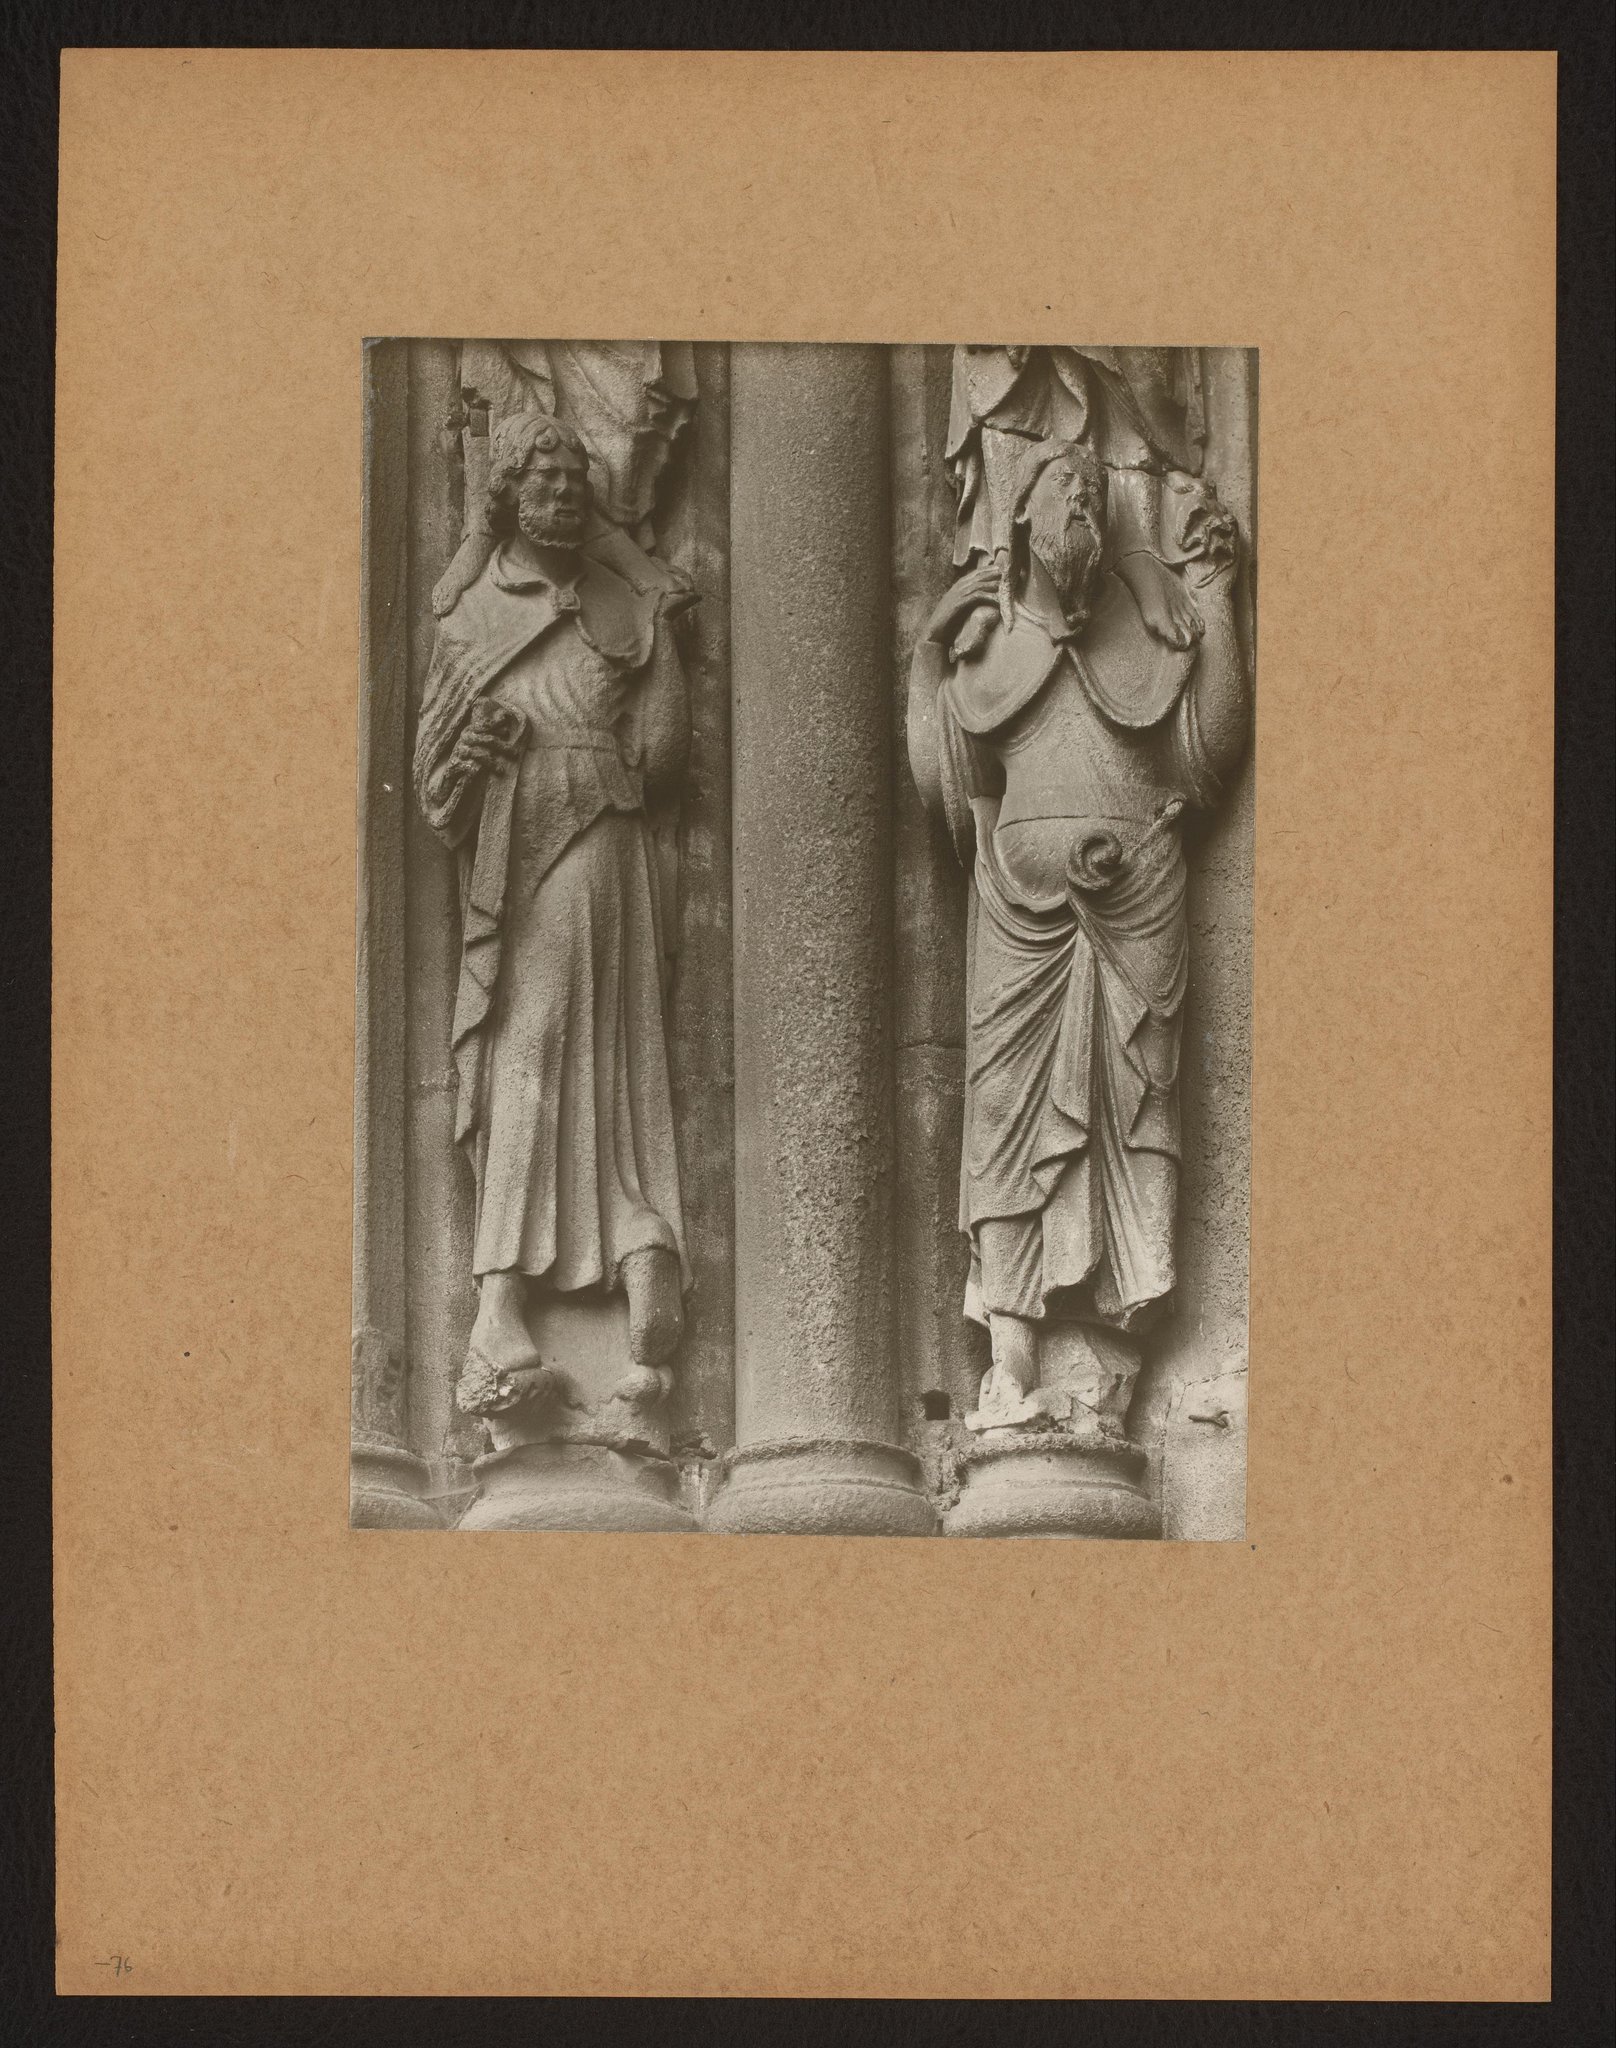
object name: album leaf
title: Evangelistensäule Pr. li.5.6.v.NW.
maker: Anonymous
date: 1900-1920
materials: paper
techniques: gelatin silver print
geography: bamberg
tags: church (exterior)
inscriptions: number: ‘78’